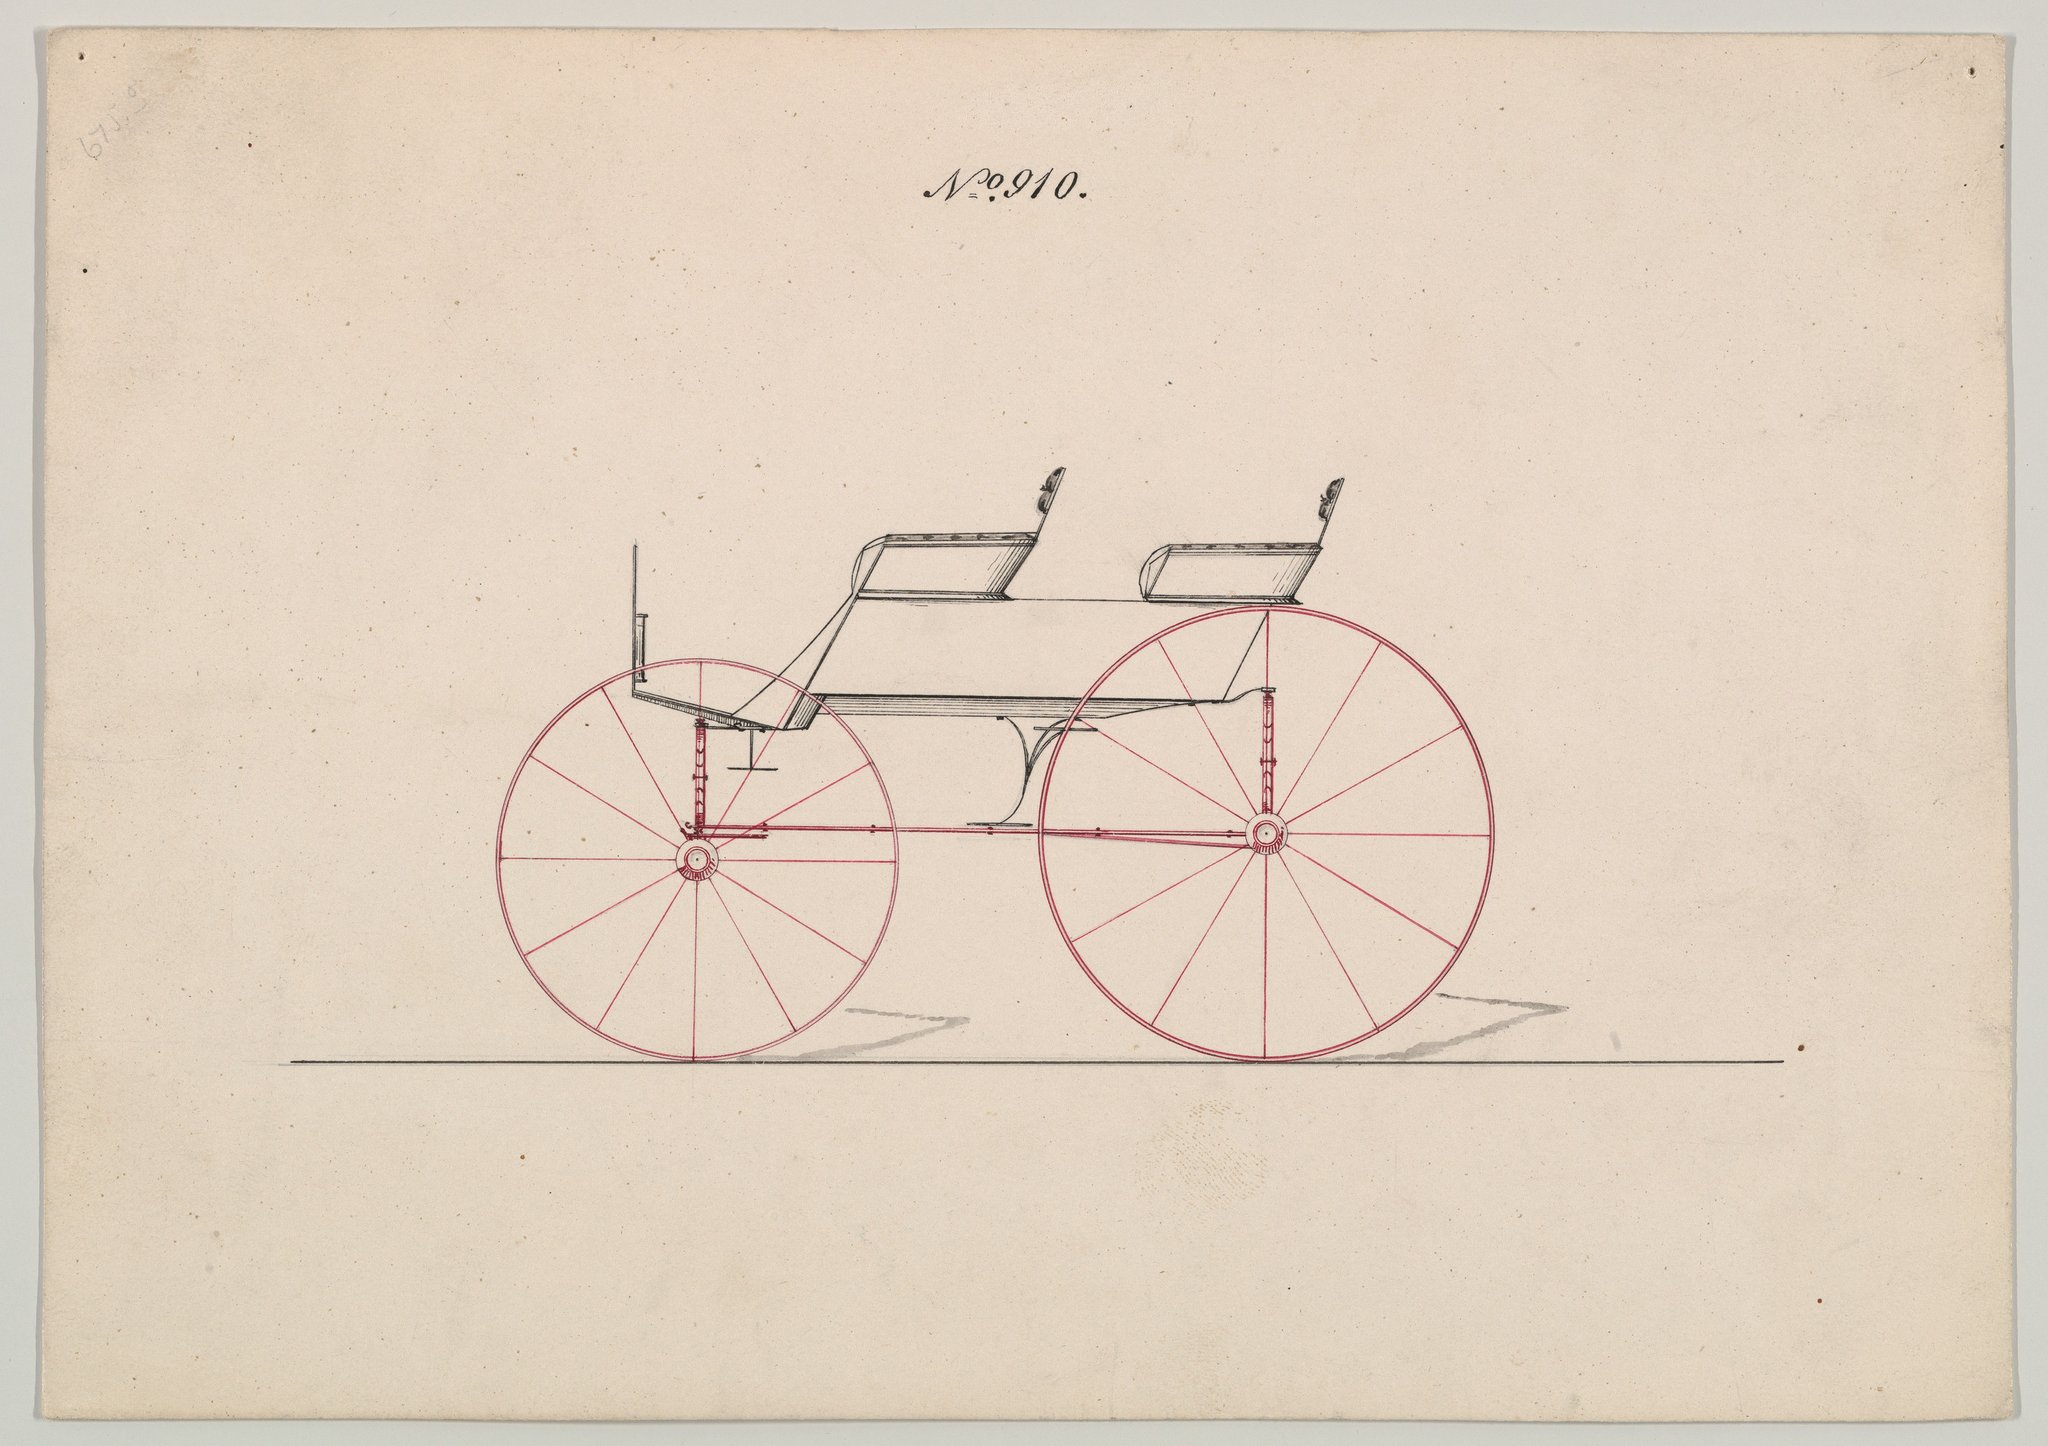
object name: drawing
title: Design for Wagon, no. 910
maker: brewster & co.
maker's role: manufacturer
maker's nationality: american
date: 1870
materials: gouache, watercolor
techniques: pen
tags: carriages